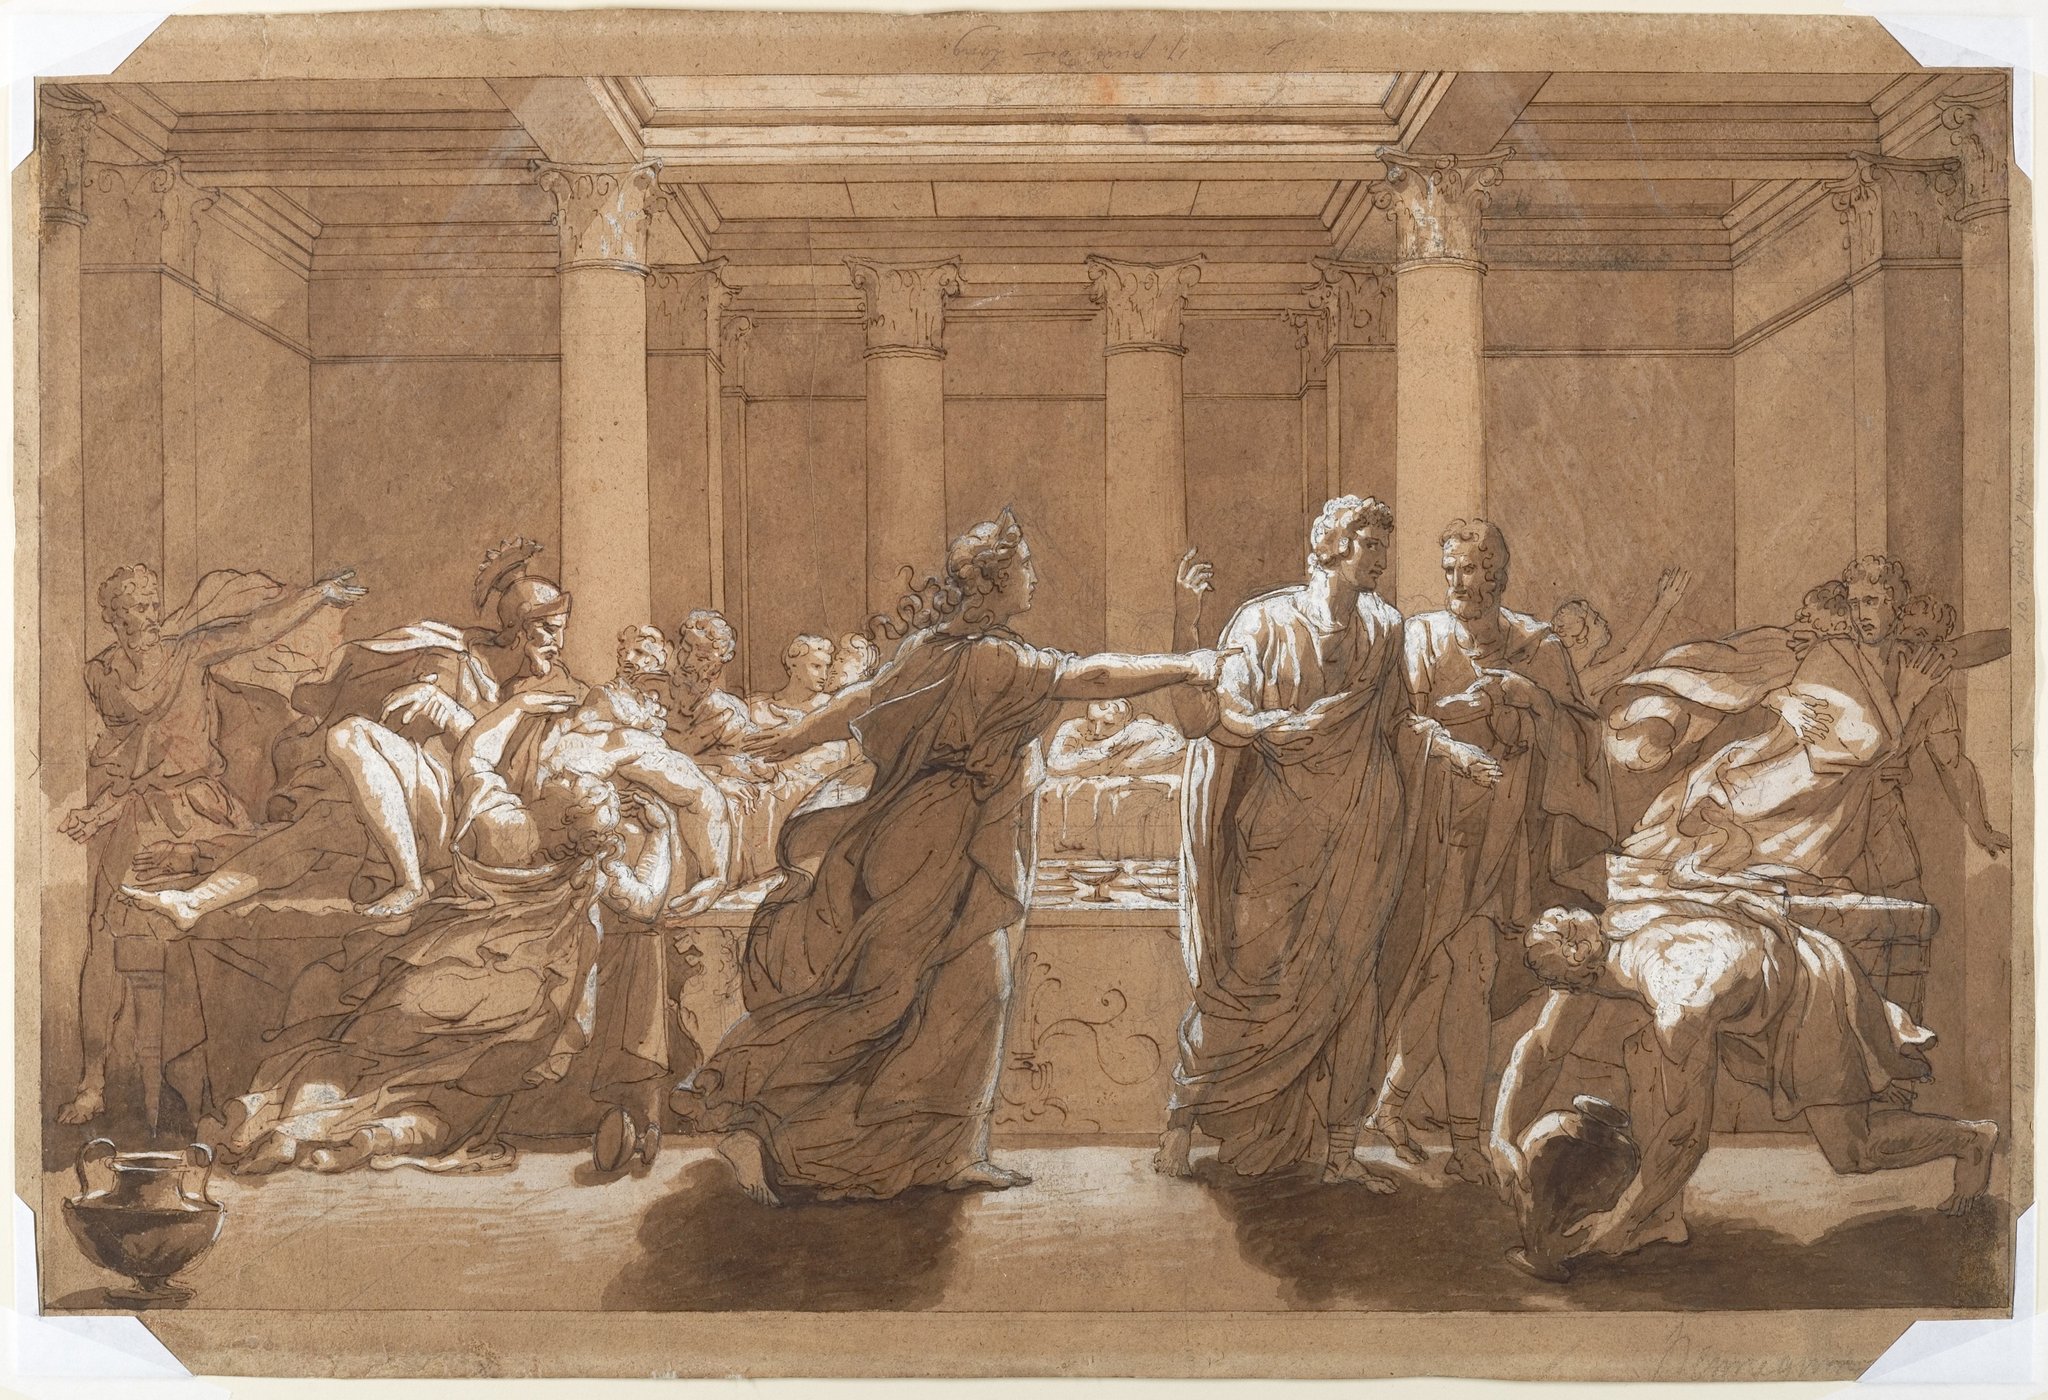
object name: drawing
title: The Death of Britannicus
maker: alexandre denis abel de pujol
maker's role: artist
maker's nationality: french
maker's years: 1785-1861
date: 1814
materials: chalk, gouache, graphite, ink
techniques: brush, heightening, pen, wash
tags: men,women